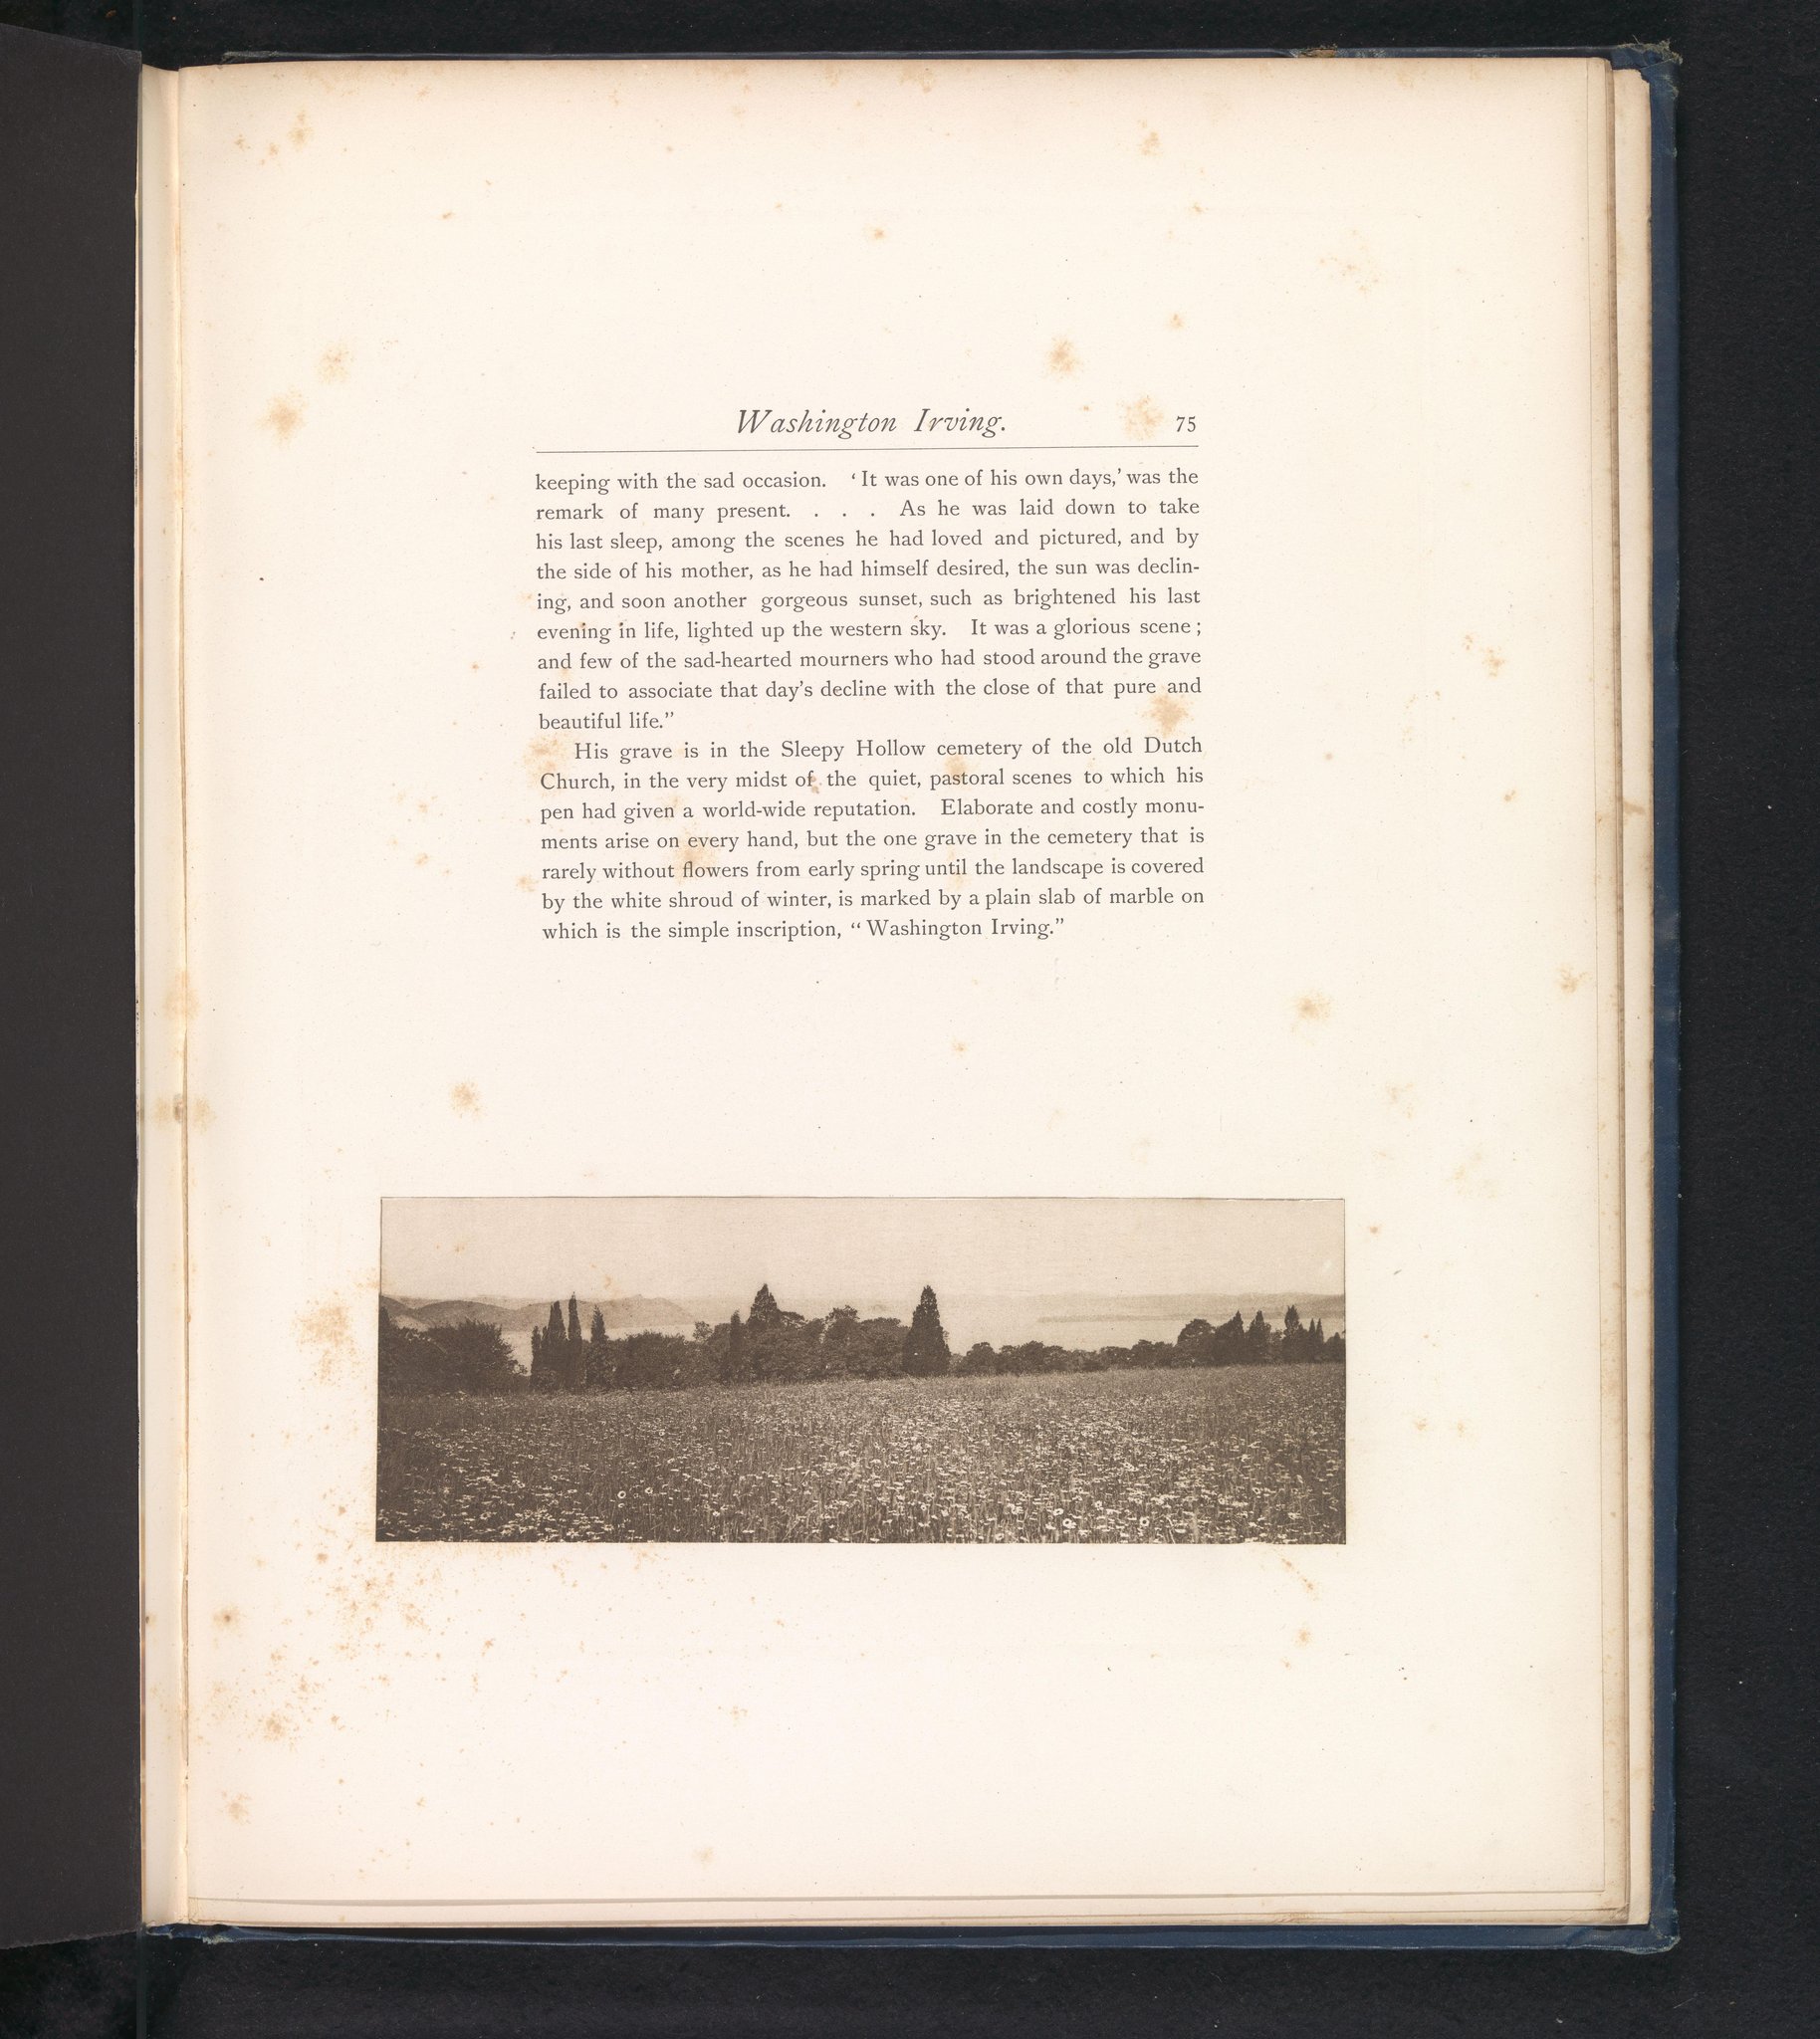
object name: photomechanical print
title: Gezicht op een veld met bloemen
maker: james leon williams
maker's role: fotograaf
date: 1882-1887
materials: paper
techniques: photoaquatint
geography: new york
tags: flowers, field filled with a crop